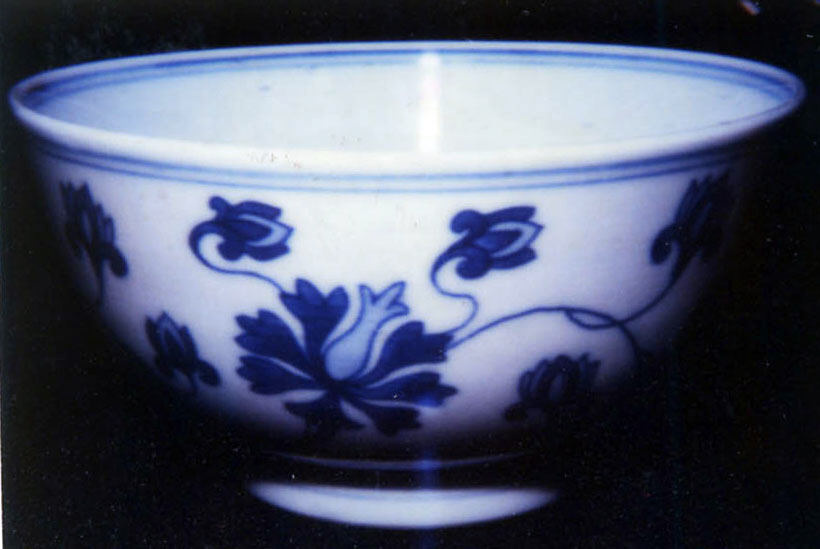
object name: bowl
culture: chinese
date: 1901-2000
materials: porcelain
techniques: painting, underglaze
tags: flowers